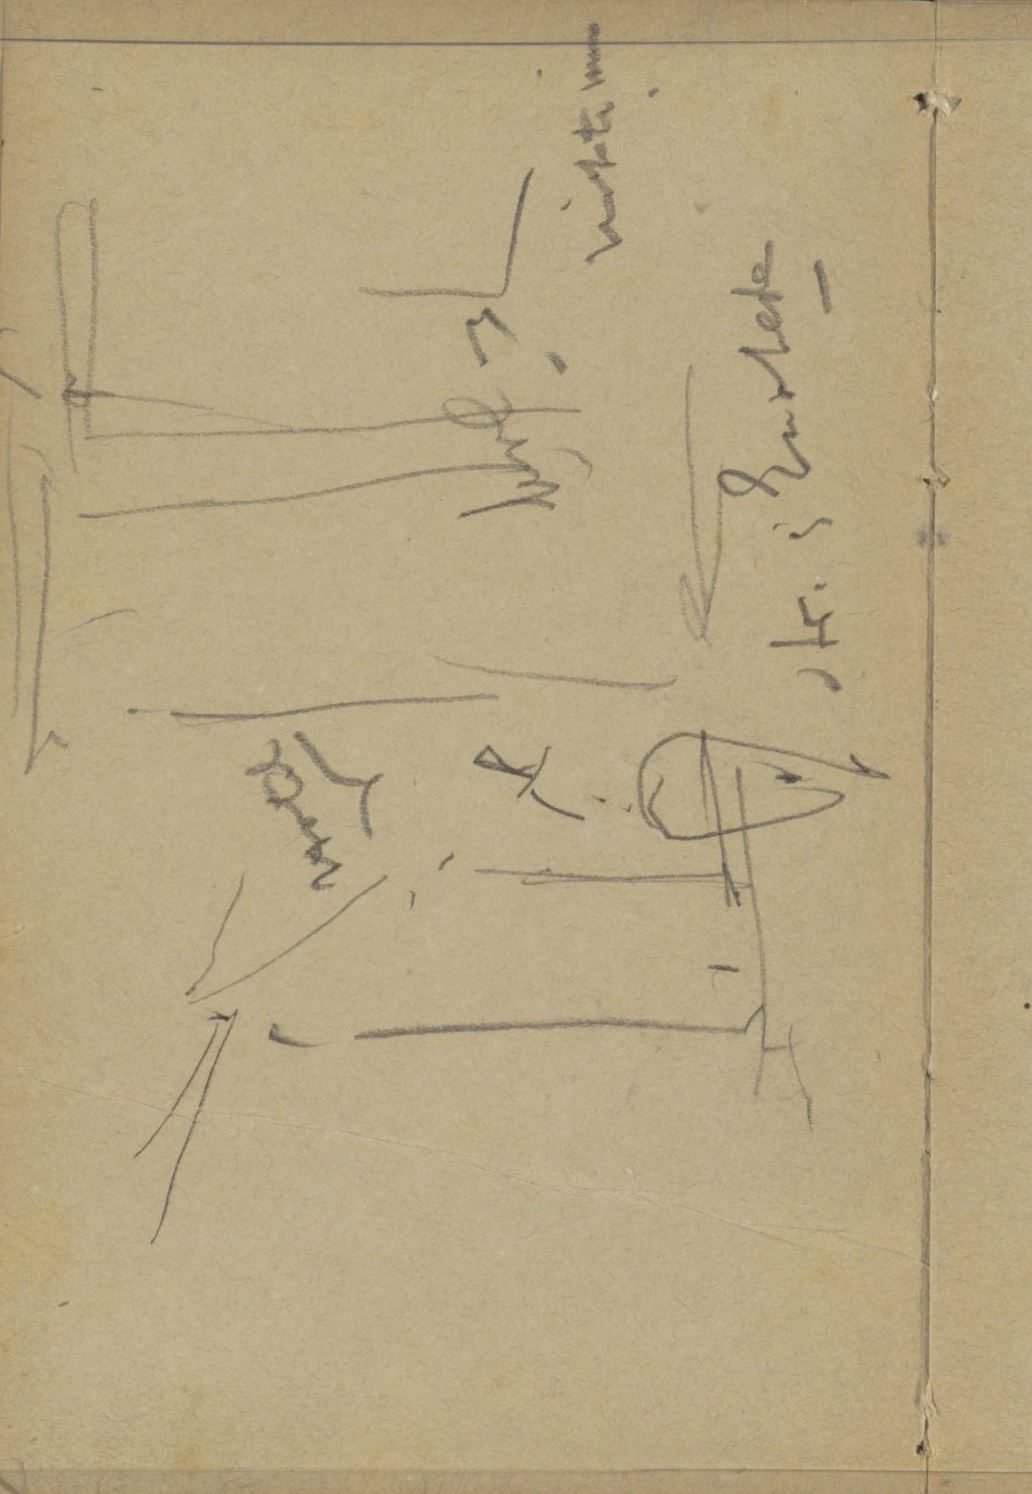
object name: sketchbook leaf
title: Gezicht op een straat in Enschede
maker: george hendrik breitner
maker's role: draughtsman, painter, print maker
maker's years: 1857-1923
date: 1887-1891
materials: paper, pencil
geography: enschede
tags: street (+ city(-scape) with figures, staffage)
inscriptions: annotation: ‘str. in Enschede’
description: Pagina 5 uit een schetsboek met 83 bladen.